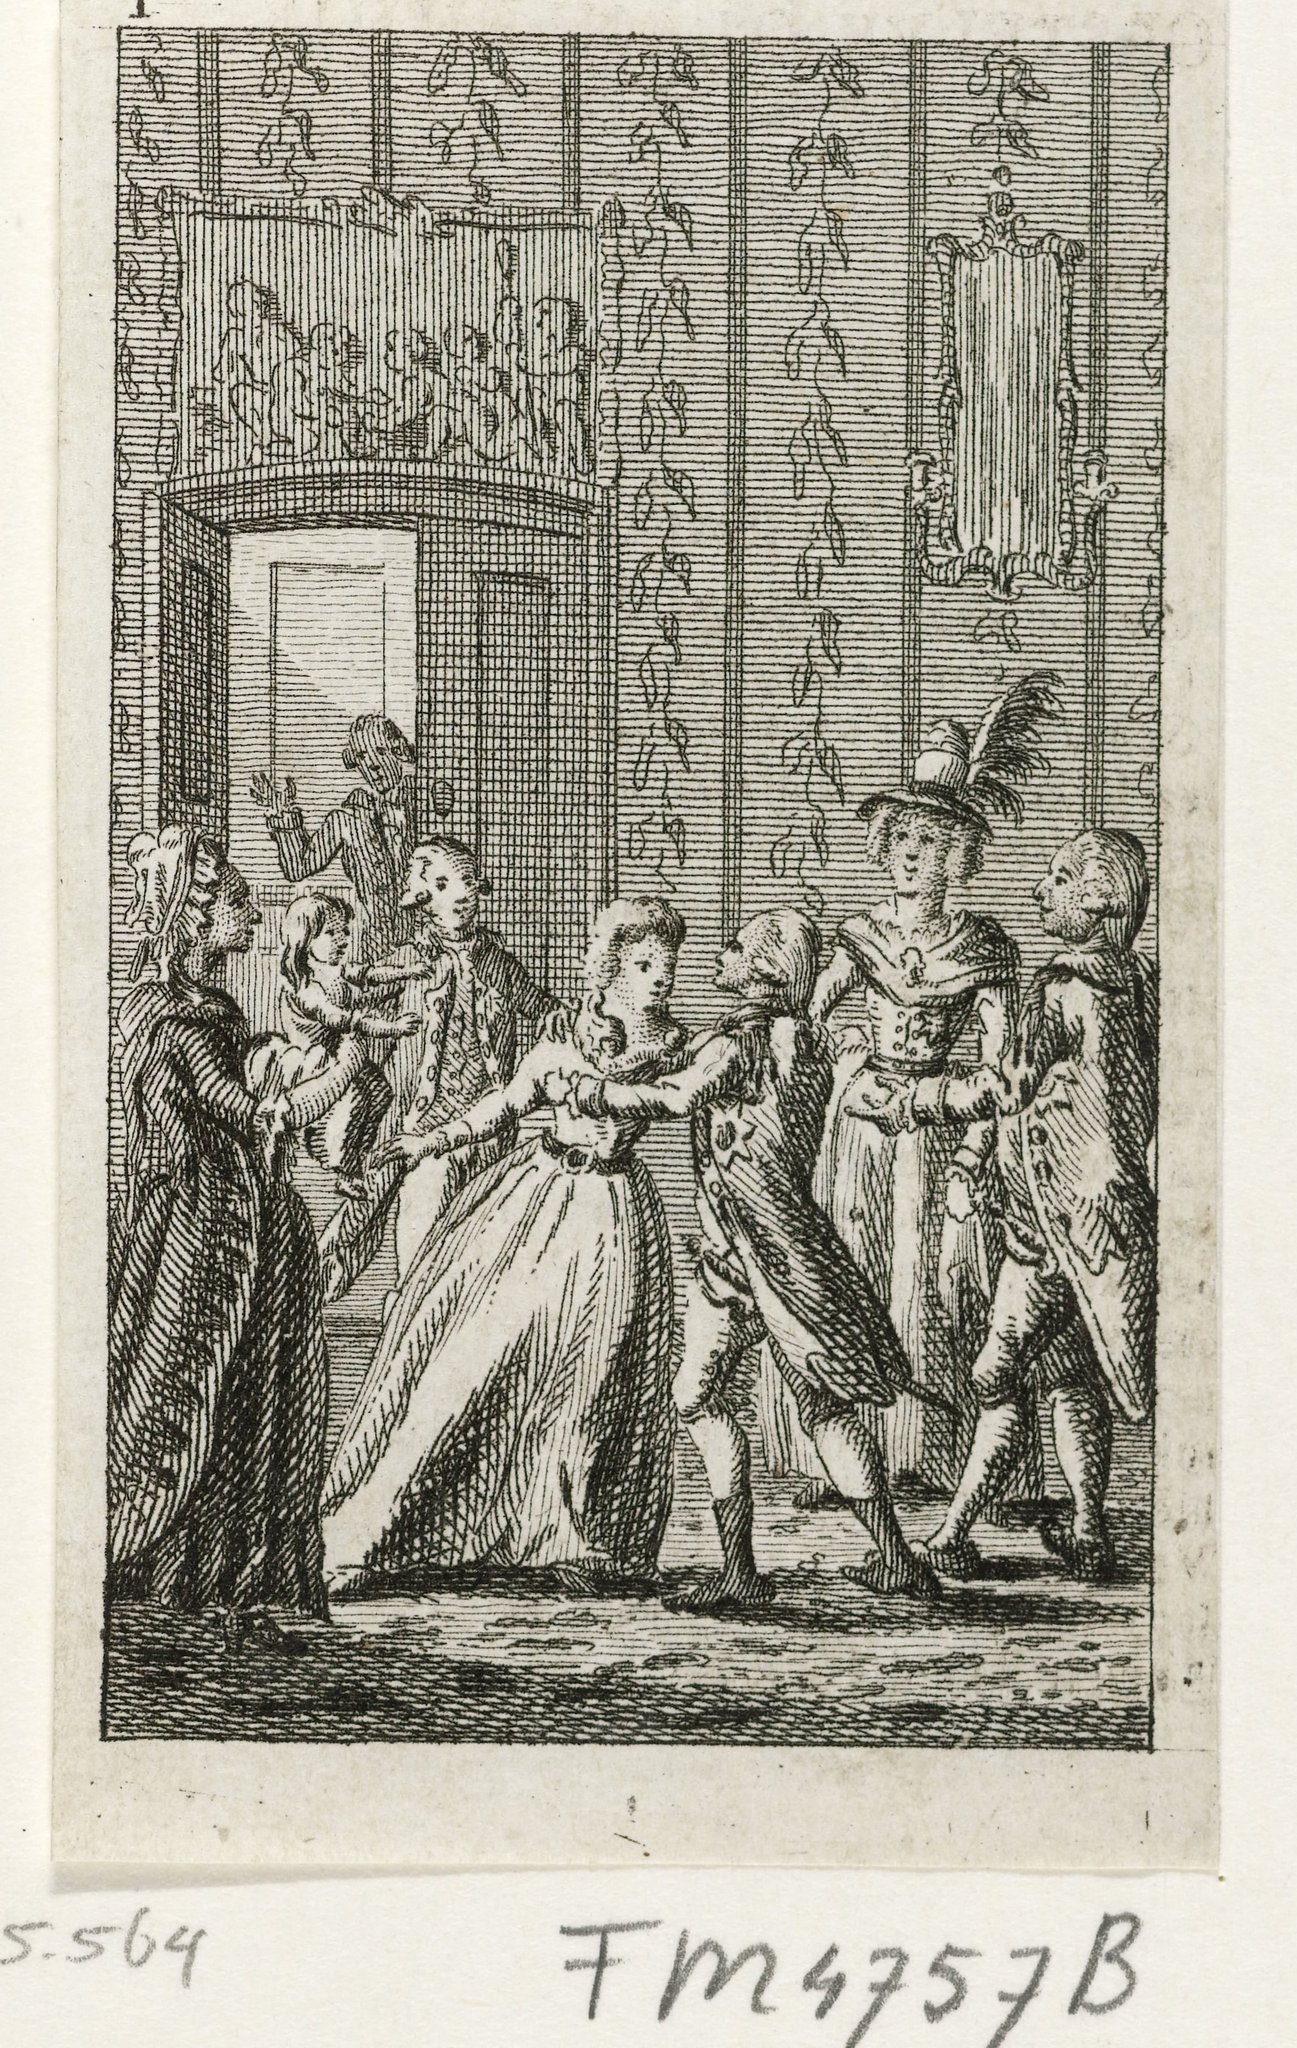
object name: print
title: Vorst neemt afscheid van zijn gezin, almanakplaatje van ca. 1786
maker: Anonymous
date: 1786-1790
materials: paper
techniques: etching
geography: northern netherlands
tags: patriots (1780-1795)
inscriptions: collector's mark: Lugt 2228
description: Interieur met een vorst die afscheid neemt van zijn gezin, onderdeel van een groep van 6 plaatjes uit een almanak van ca. 1786. Gemerkt bovenaan: I.